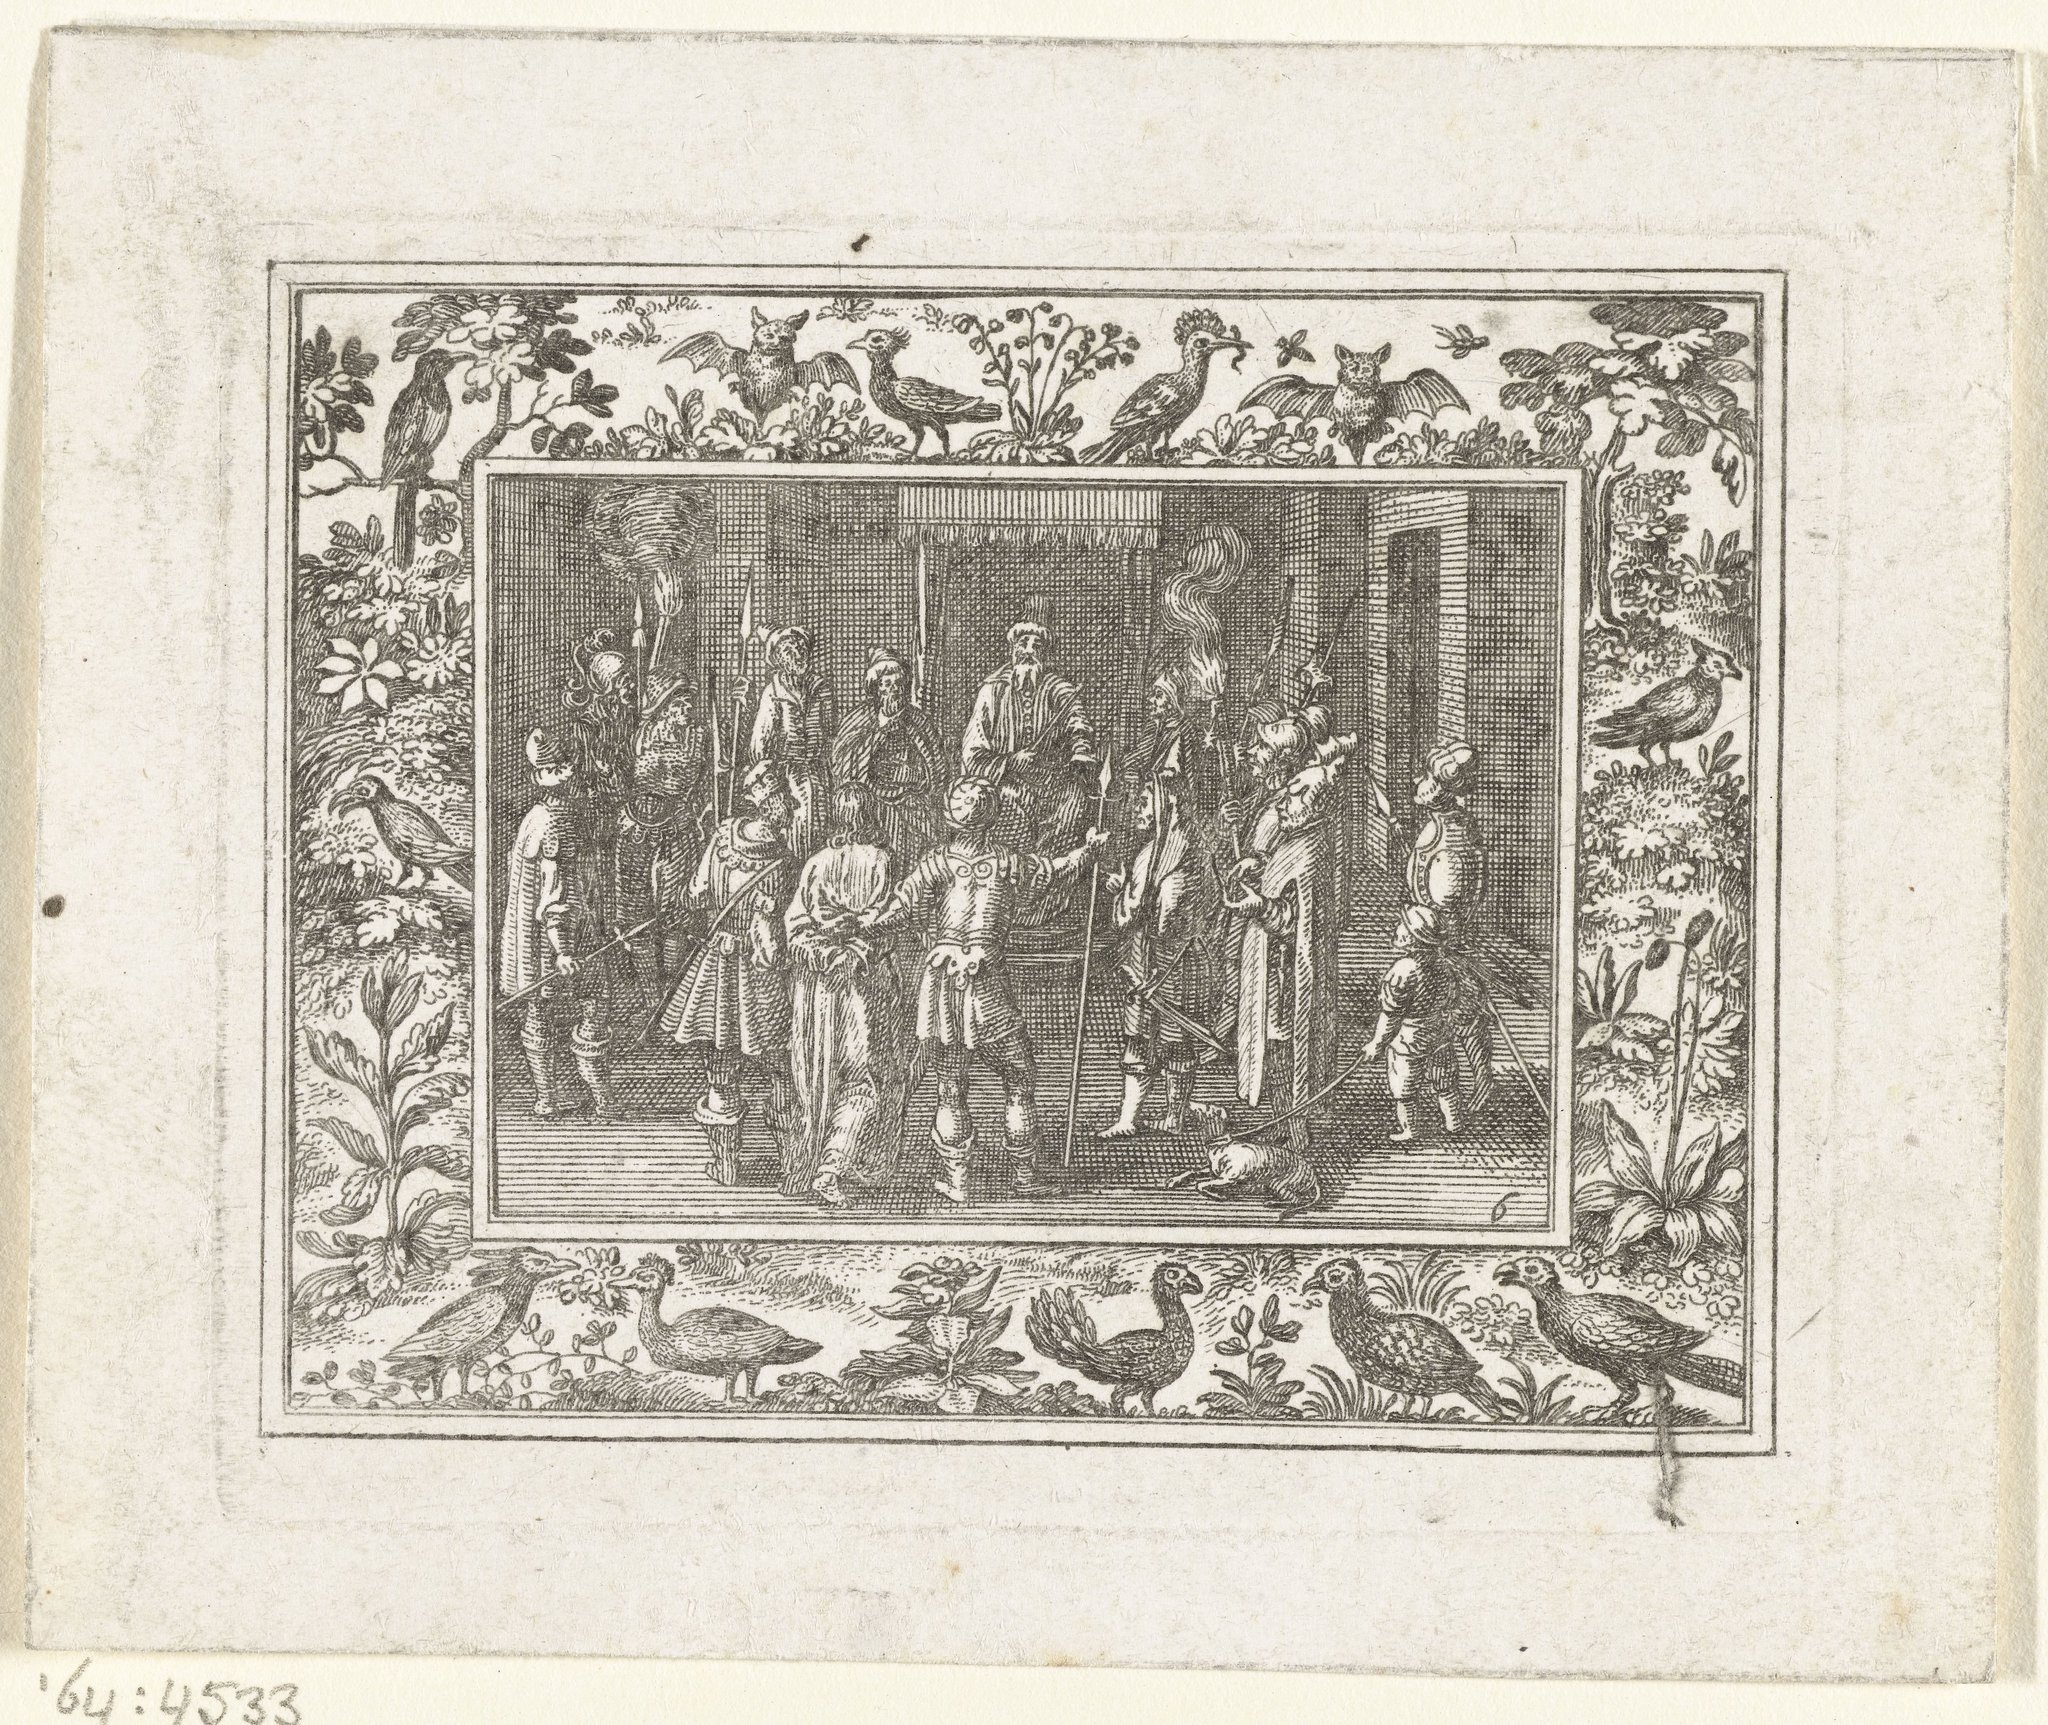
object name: print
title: Passievoorstellingen in lijsten met dieren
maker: Anonymous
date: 1600-1699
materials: paper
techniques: etching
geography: germany